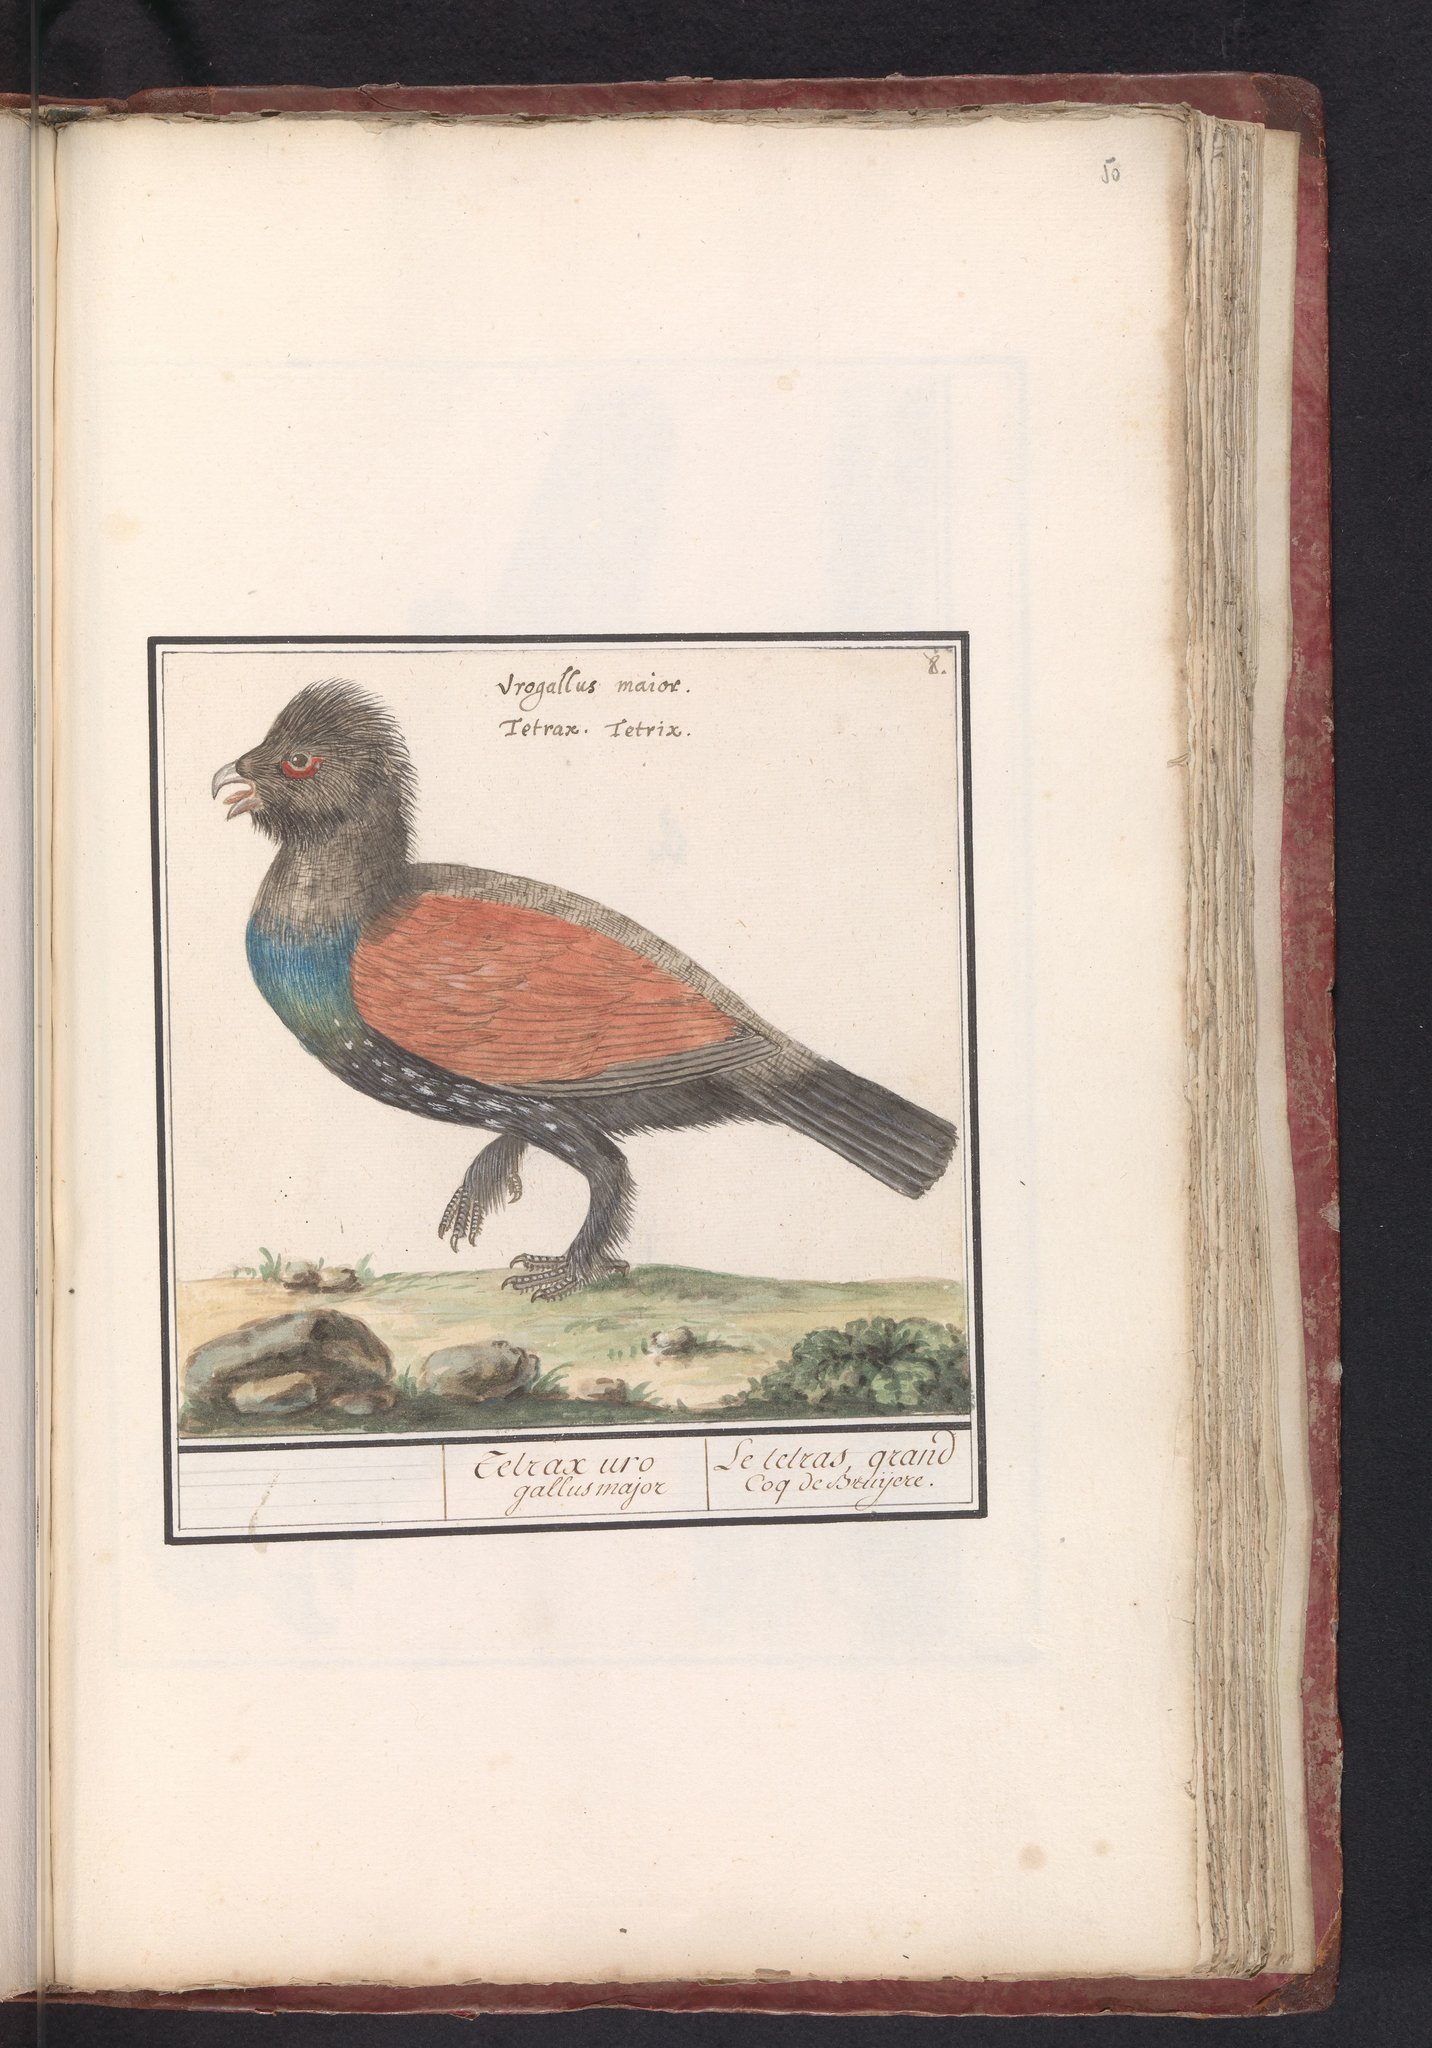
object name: drawing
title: Tetrax uro gallus major / Le tetras grand Coq de Bruijere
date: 1596-1610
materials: paint, paper, pencil, watercolor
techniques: brush, pen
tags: walker and runner birds: western capercaillie, walker and runner birds: grouse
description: Ruigpoothoender, mogelijk een auerhoen of een korhoen. Genummerd rechtsboven: 8. Bovenaan de Latijnse naam. Onderdeel van het eerste album met tekeningen van vogels. Derde van twaalf albums met tekeningen van dieren, vogels en planten bekend rond 1600, gemaakt in opdracht van keizer Rudolf II. Met toelichting in Nederlands, Latijn en Frans.